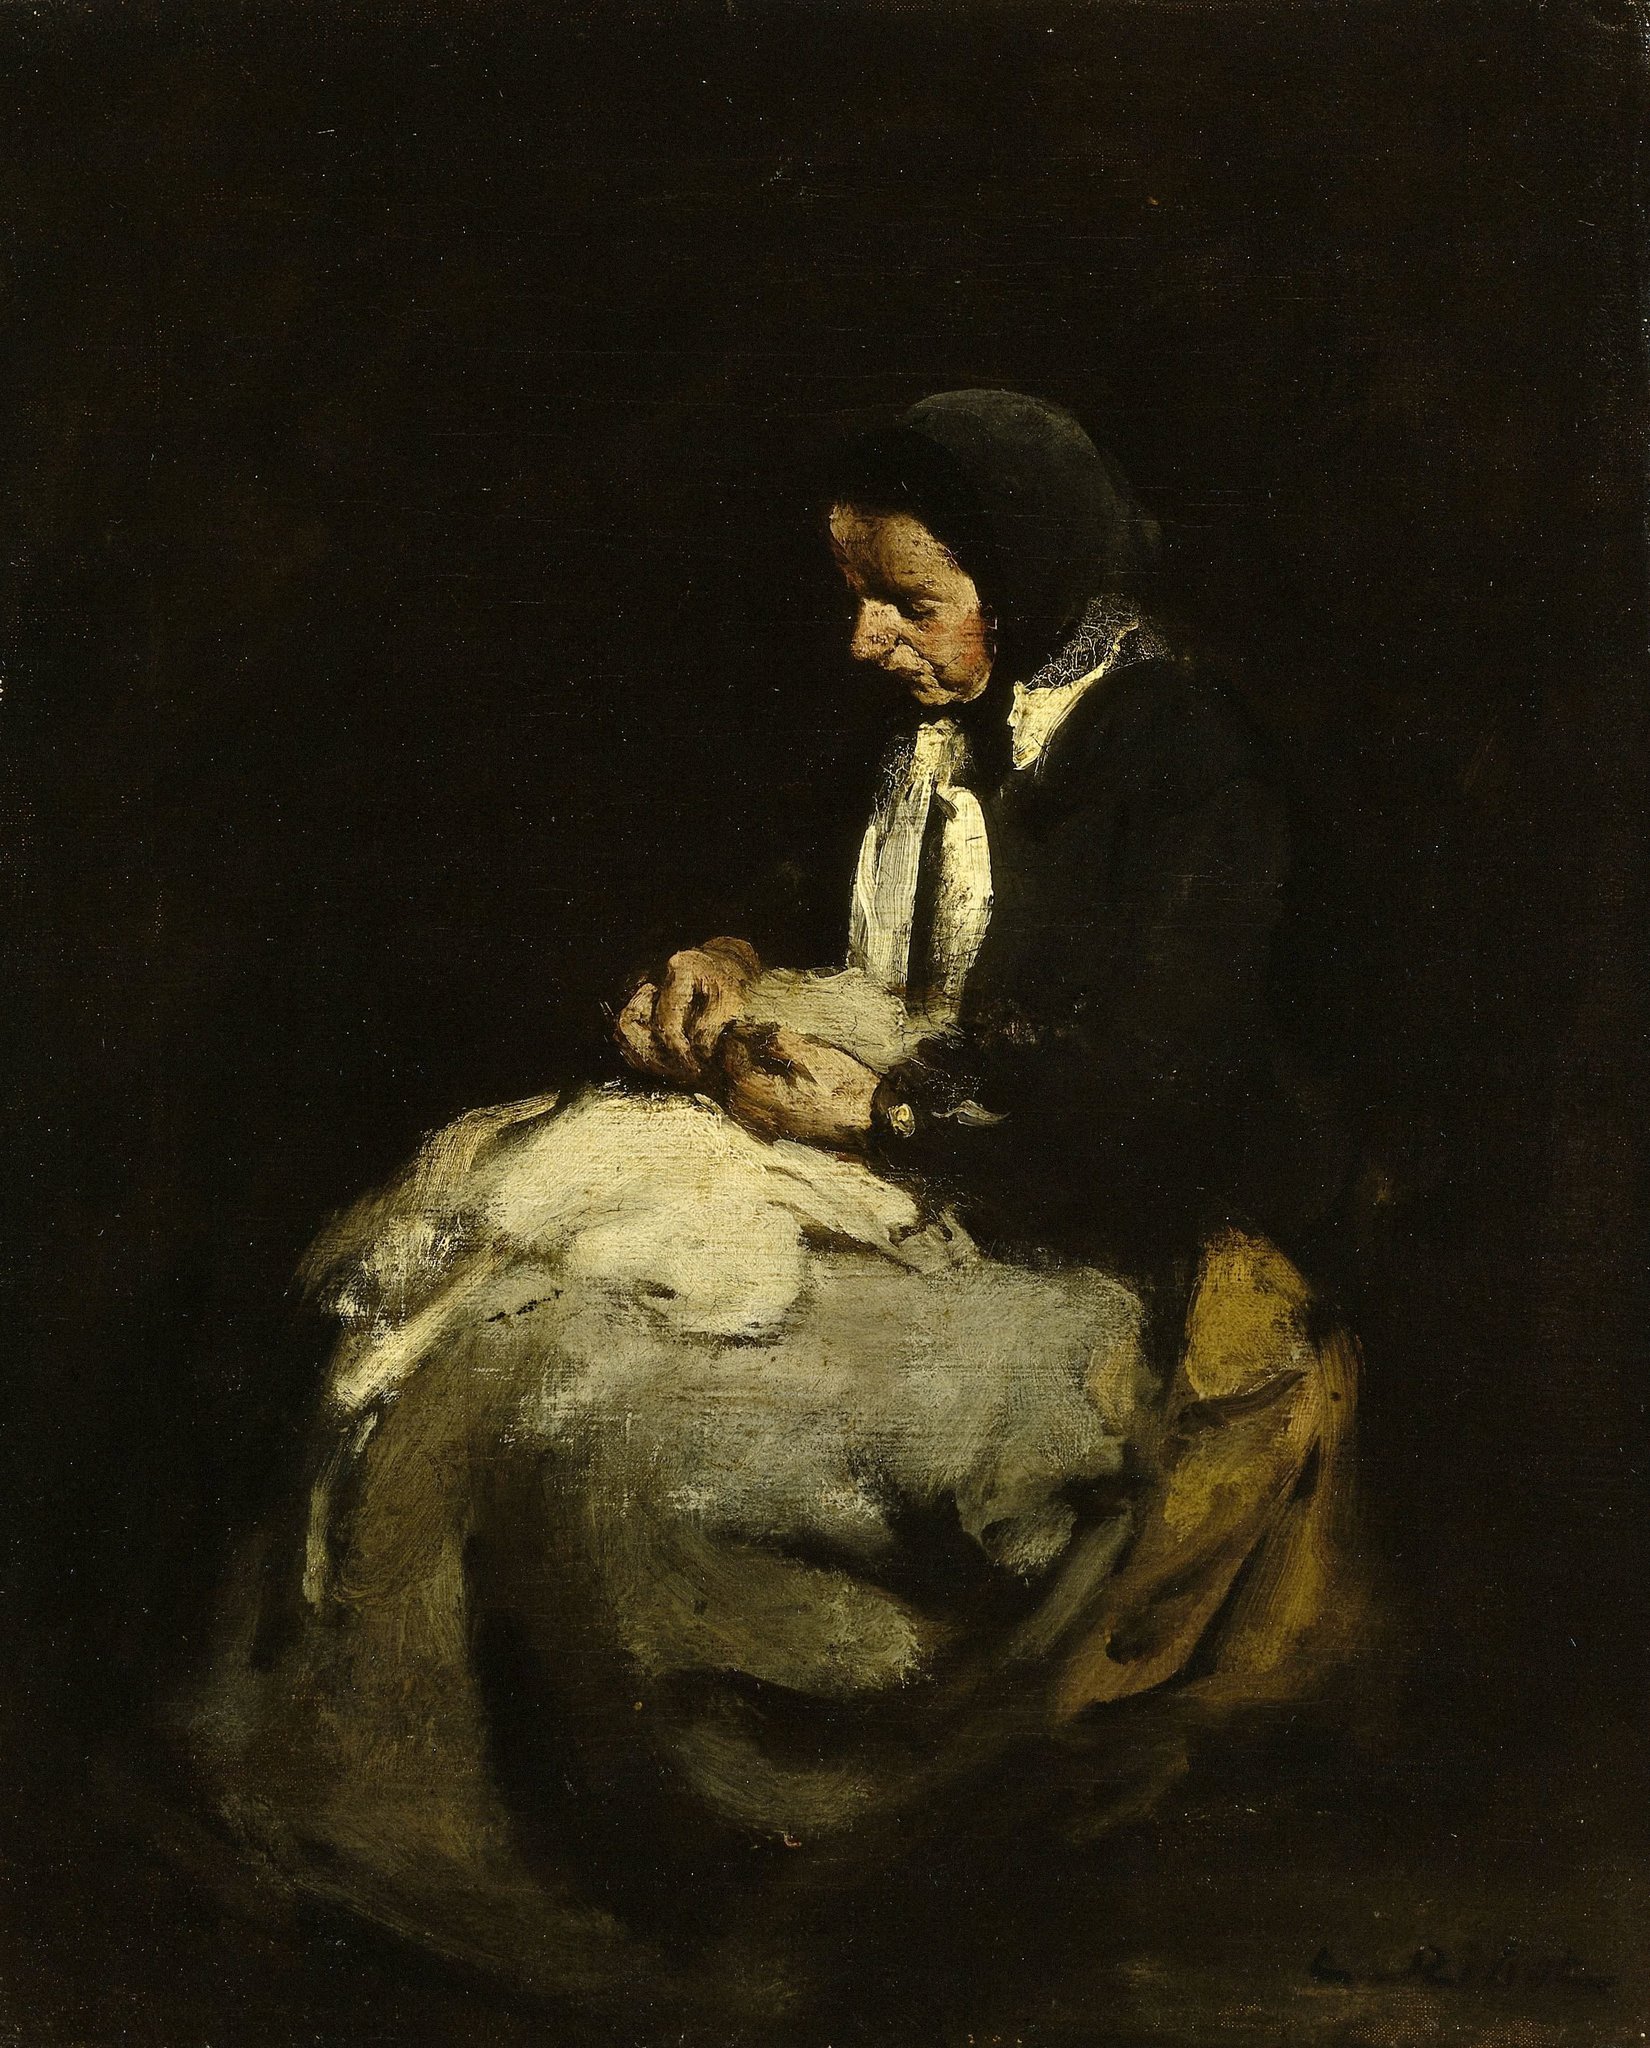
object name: painting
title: Woman sewing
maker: théodule augustin ribot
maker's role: draughtsman, painter, print maker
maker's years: 1823-1891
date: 1850-1891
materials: canvas, oil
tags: mending, repairing ~ clothes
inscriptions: signature: ‘t. Ribot’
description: De naaister. Een zittende vrouw met een hoofddoek is bezig met verstelwerk aan kleding.